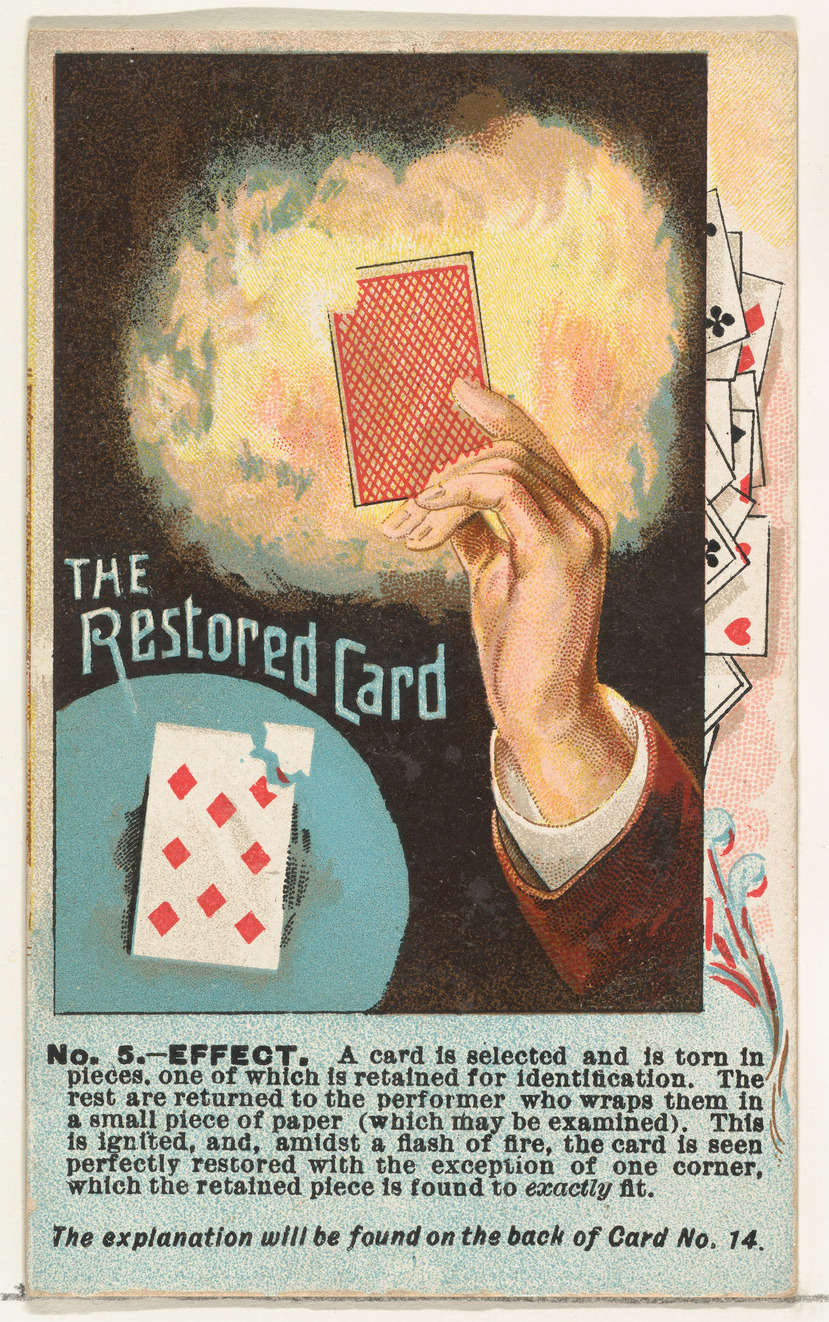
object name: print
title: Number 5, The Restored Card, from the Tricks with Cards series (N138) issued by W. Duke, Sons & Co. to promote Honest Long Cut Tobacco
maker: w. duke, sons & co.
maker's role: publisher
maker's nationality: american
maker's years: 1870-1920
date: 1887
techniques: color lithograph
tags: magic,playing cards